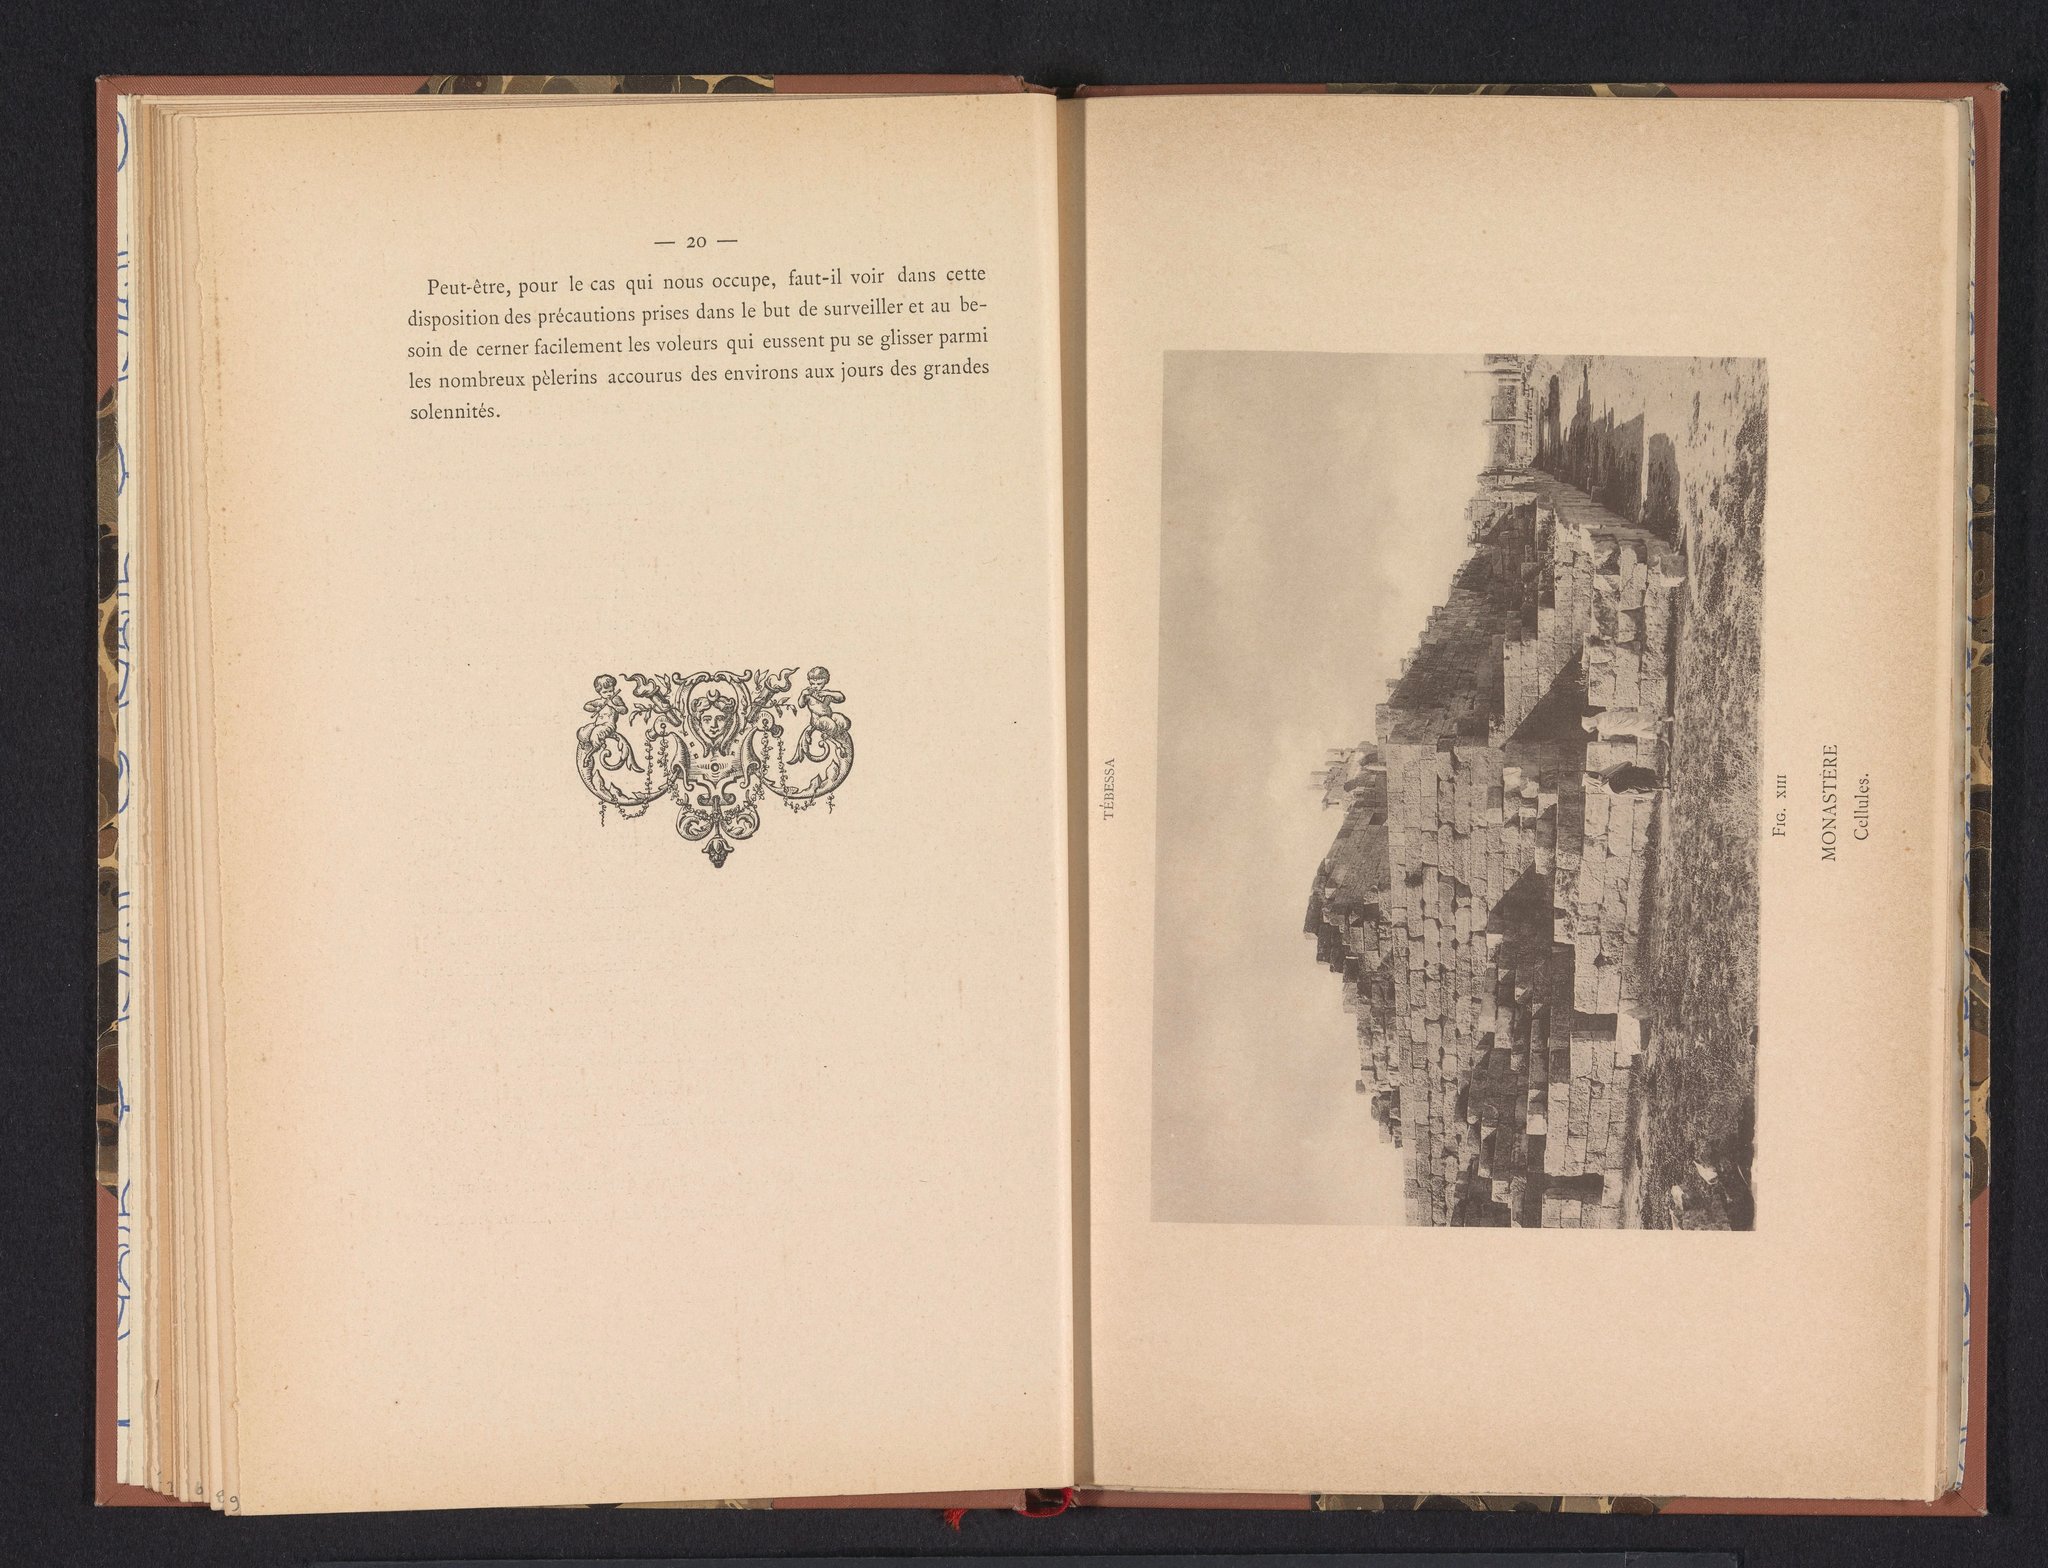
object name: photomechanical print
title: Monastère Cellules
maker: Anonymous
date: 1884-1894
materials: paper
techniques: photograph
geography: tébessa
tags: cell ~ monastery, ruin of church, monastery, etc.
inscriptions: number: ‘Fig. XIII’